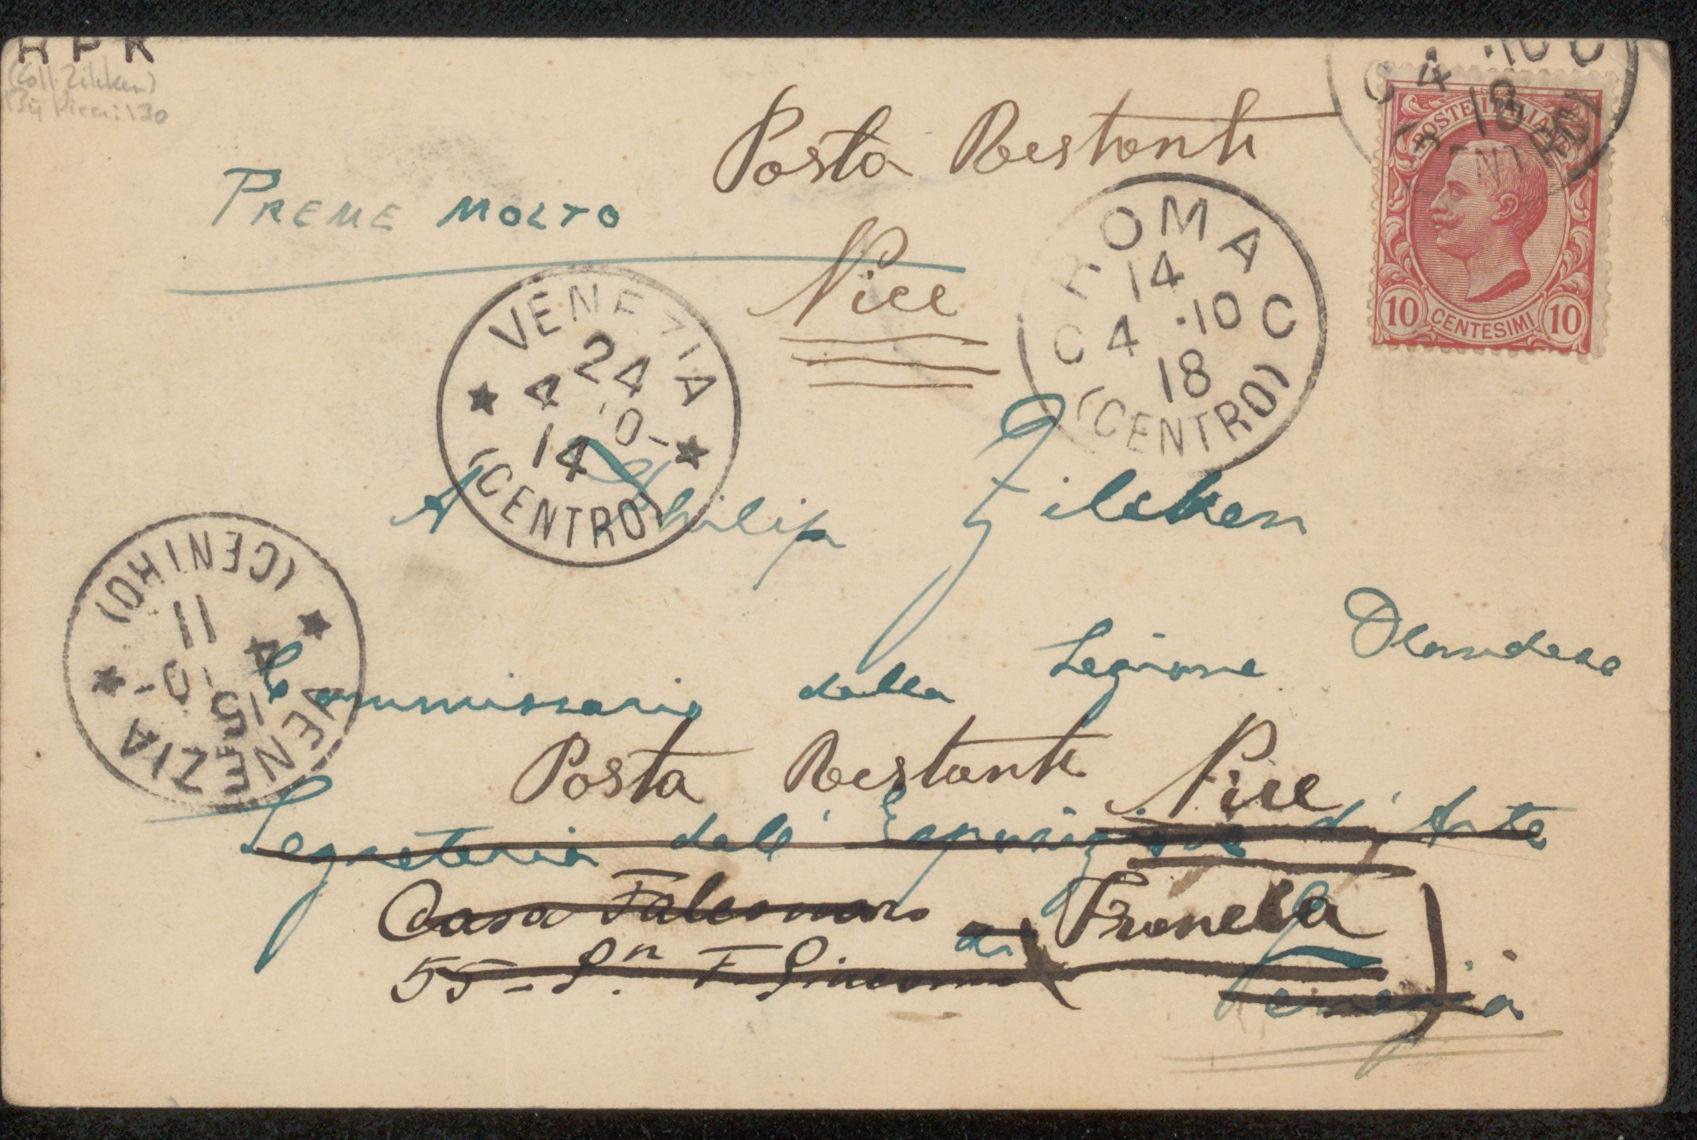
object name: letter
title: Brief aan Philip Zilcken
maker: vittorio pica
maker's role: criticus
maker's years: 1864-1930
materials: cardboard, ink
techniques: pen, printing, writing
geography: rome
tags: print maker, jozef israëls, painter, draughtsman, philip zilcken, photography, cinematography, painting (including book-illumination, miniature-painting)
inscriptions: collector's mark: ‘RPK’